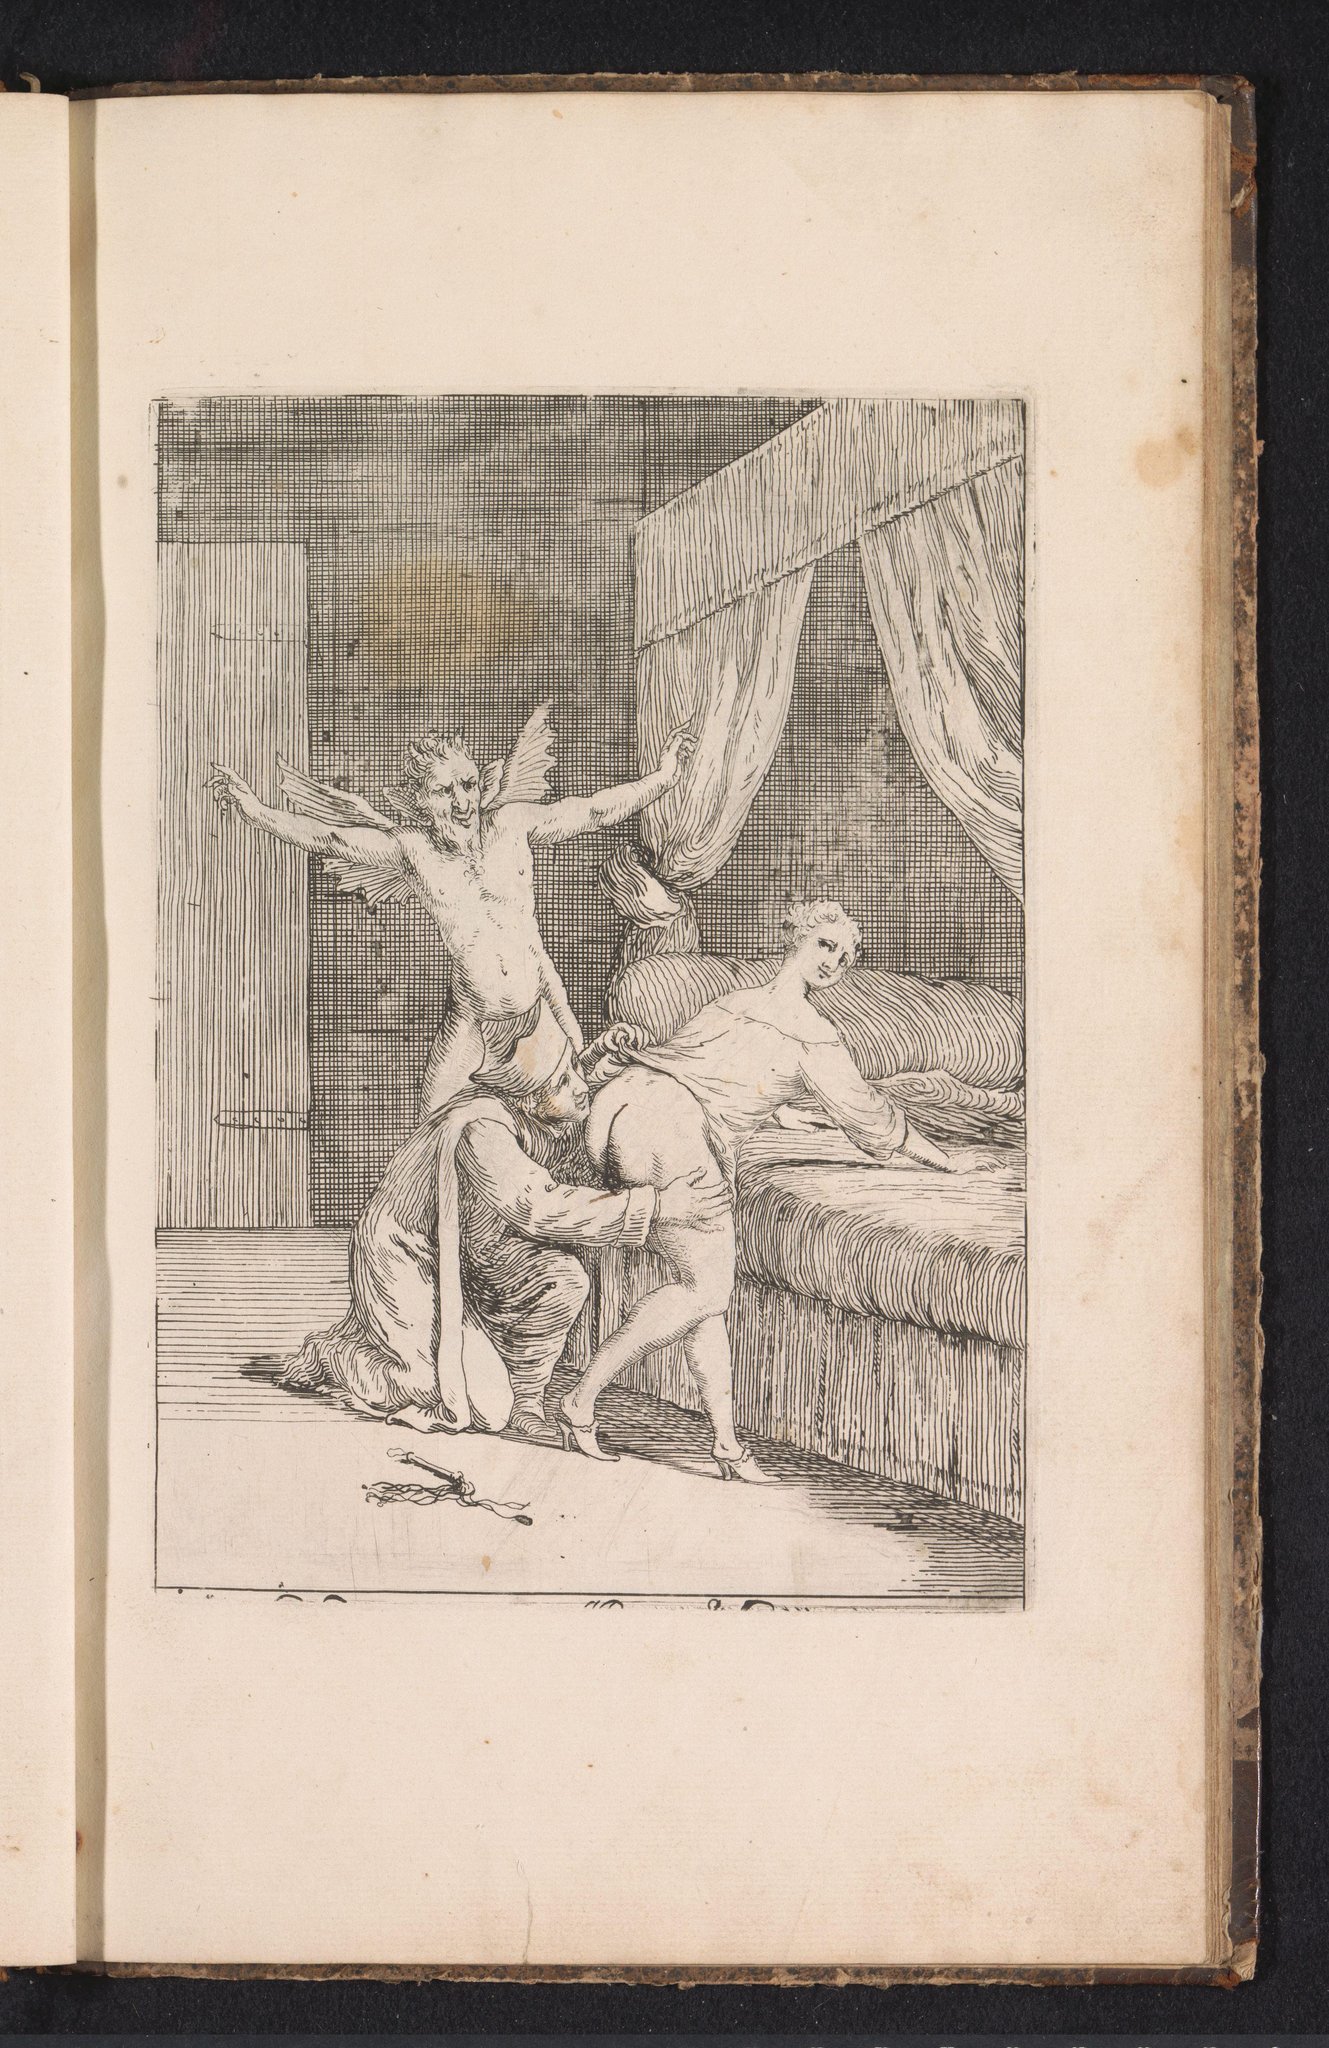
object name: print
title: Jean-Baptiste Girard streelt Marie-Catherine Cadière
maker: jacques gabriel huquier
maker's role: draughtsman, painter, print maker, publisher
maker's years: 1725-1805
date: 1735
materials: paper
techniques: etching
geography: france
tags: toulon, witch, sorcerer with the devil and/or demons, sexual abuses of monks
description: Jean-Baptiste Girard streelt de naakte Marie-Catherine Cadière. Onderdeel van de reeks van 32, veelal erotisch getinte, prenten gewijd aan het schandaal rond Marie-Catherine Cadière en de Jezuïet Jean-Baptiste Girard in 1730-1731.